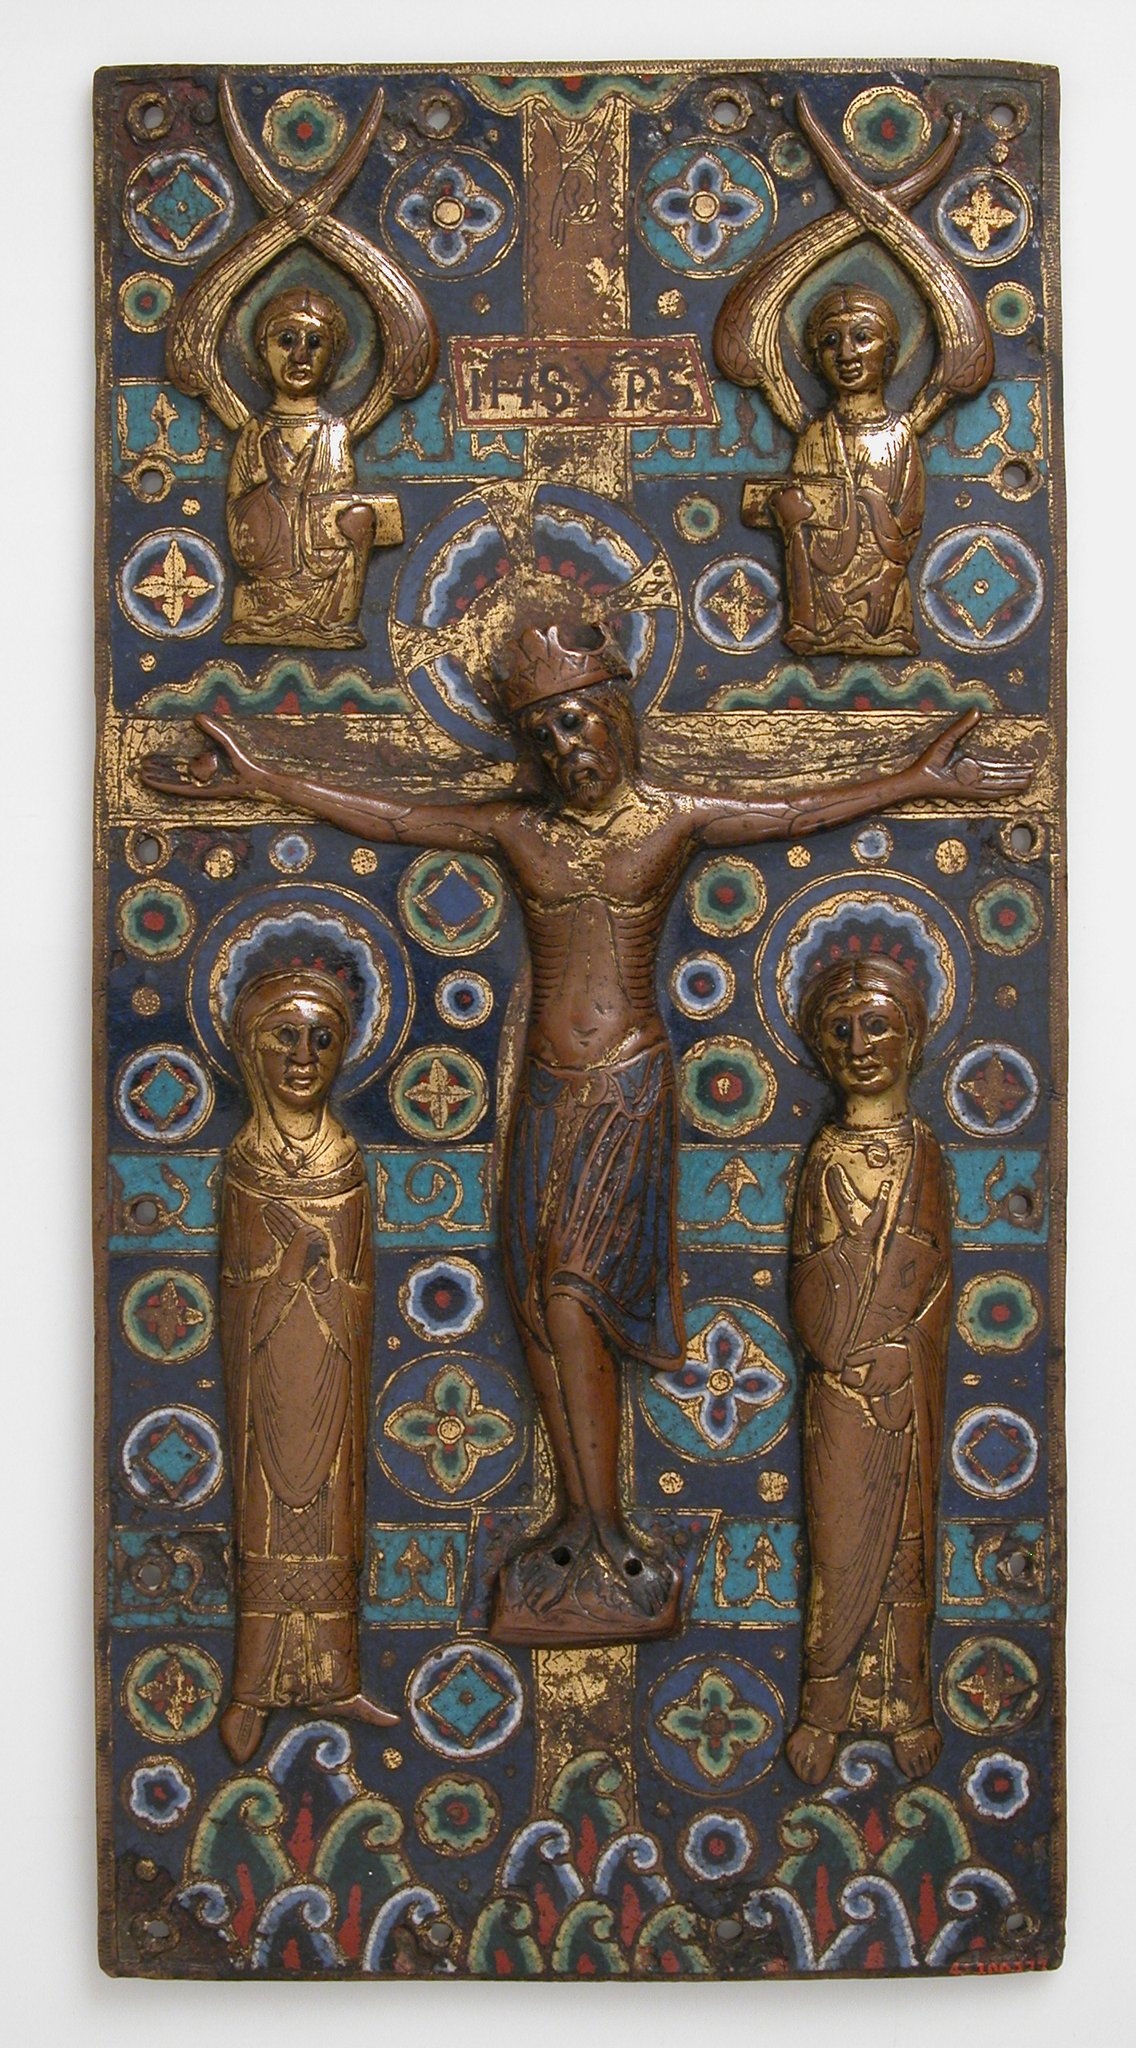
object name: book cover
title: Book-Cover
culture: french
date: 1201-1300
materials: gilt copper, enamel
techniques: enamel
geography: france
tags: angels,virgin mary,crucifixion